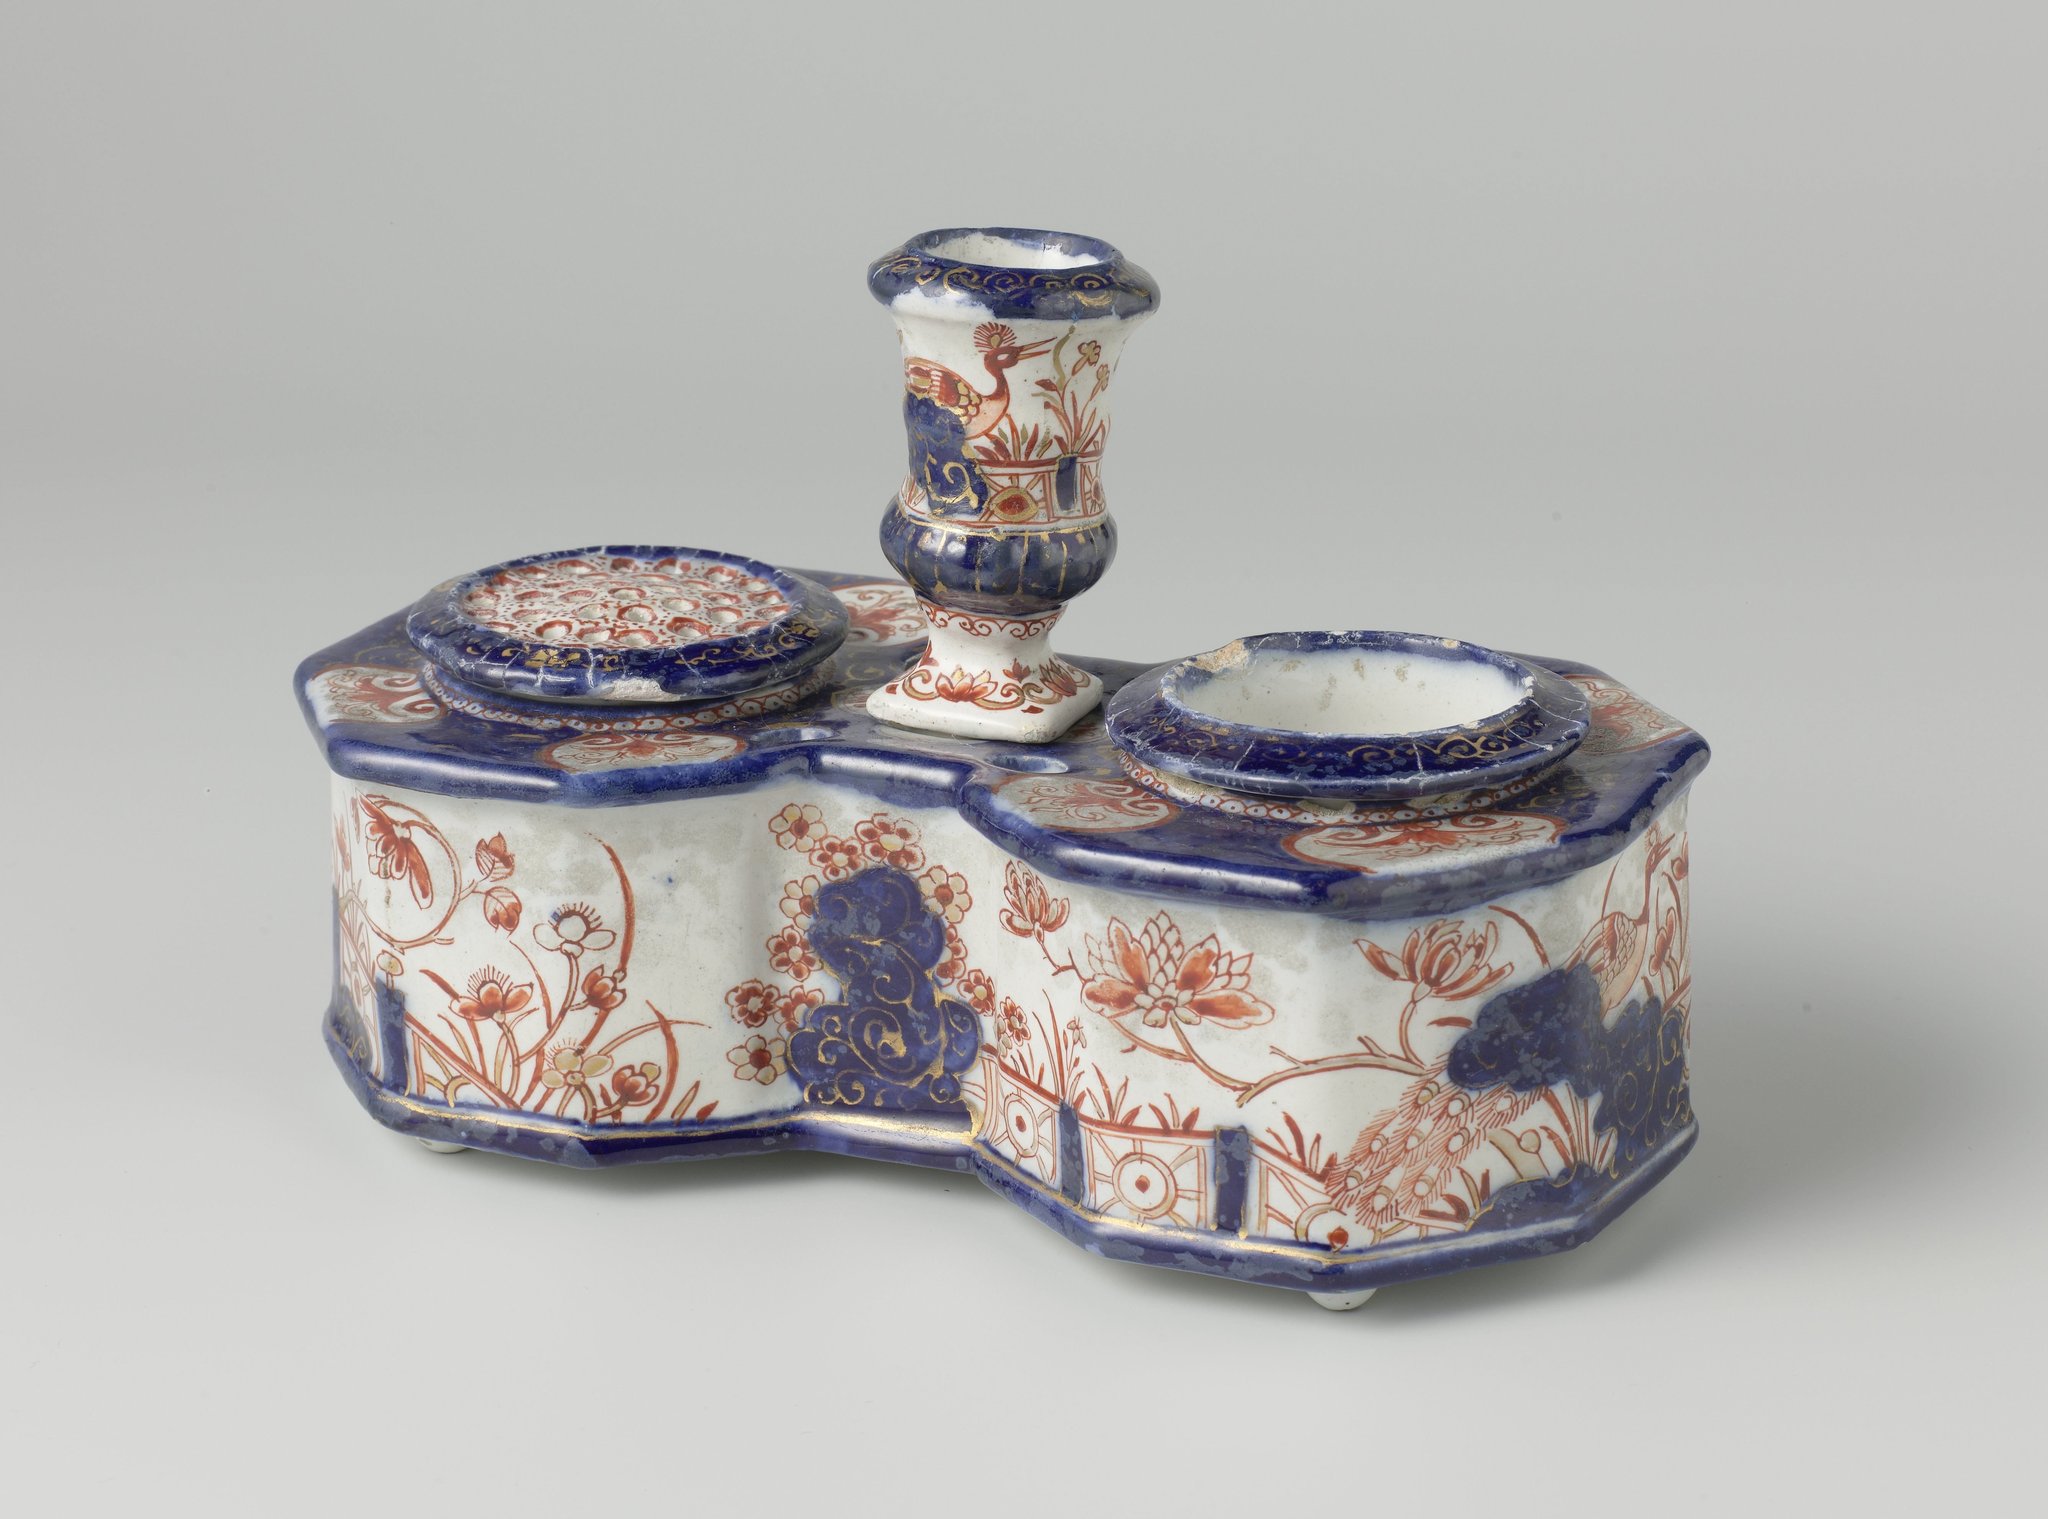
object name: inkstand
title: Inktstel van veelkleurig beschilderde faïence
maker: Anonymous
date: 1705-1725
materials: earthenware, glaze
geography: delft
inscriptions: collector's mark: ‘Collection J.F. Loudon’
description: Pennenhouder van faïence. Veelkleurig beschilderd.